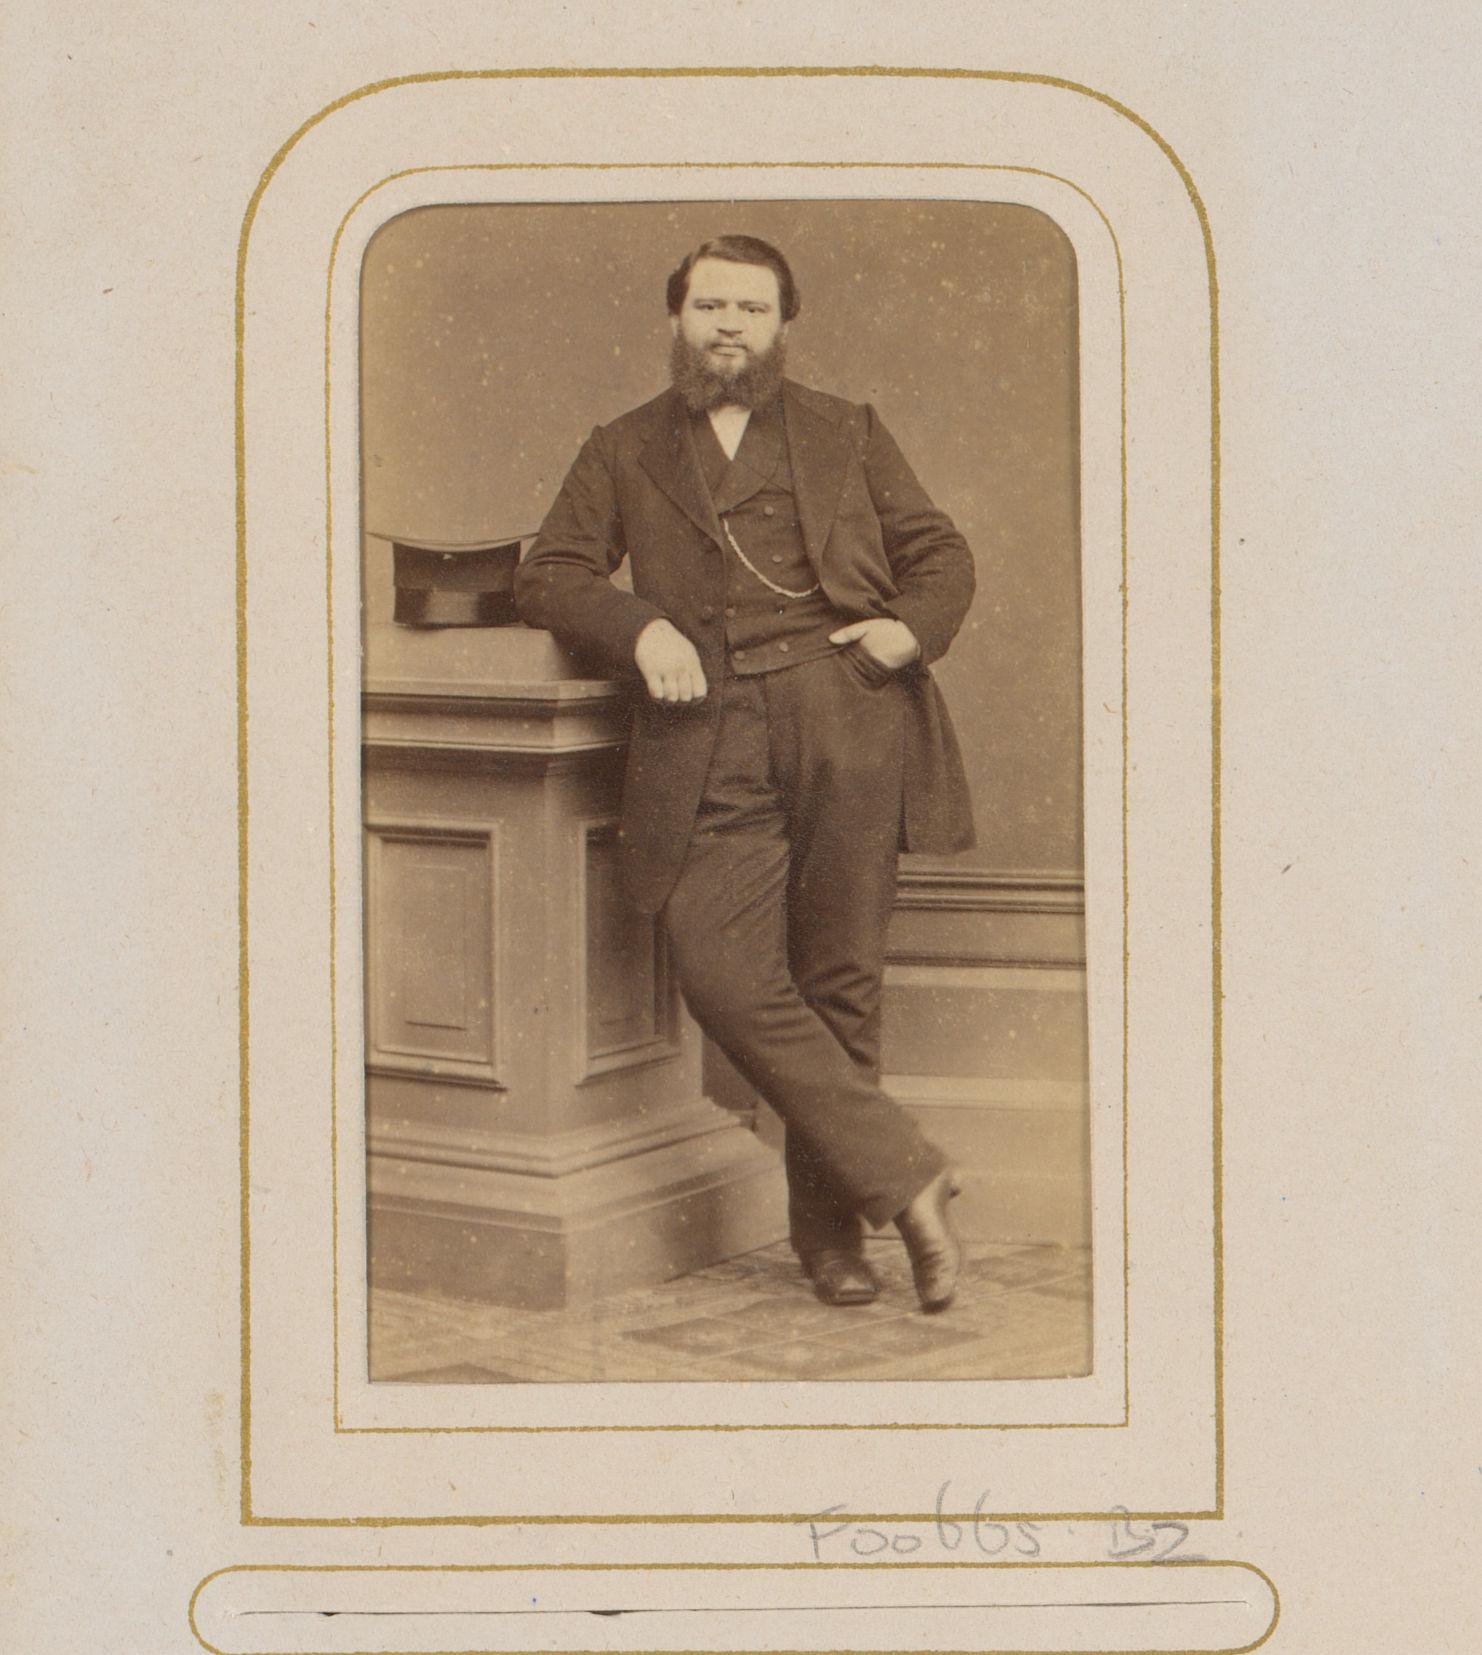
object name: album leaf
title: Portret van een man met hoge hoed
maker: franz wilhelm heinrich deutmann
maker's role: fotograaf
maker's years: 1840-1906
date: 1865-1890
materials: cardboard, photographic support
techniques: albumen print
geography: zwolle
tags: historical persons, head-gear: top hat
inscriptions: inscription: ‘F.W.H. Deutmann/ Photographie/ Zwolle/ Kamperstraat’